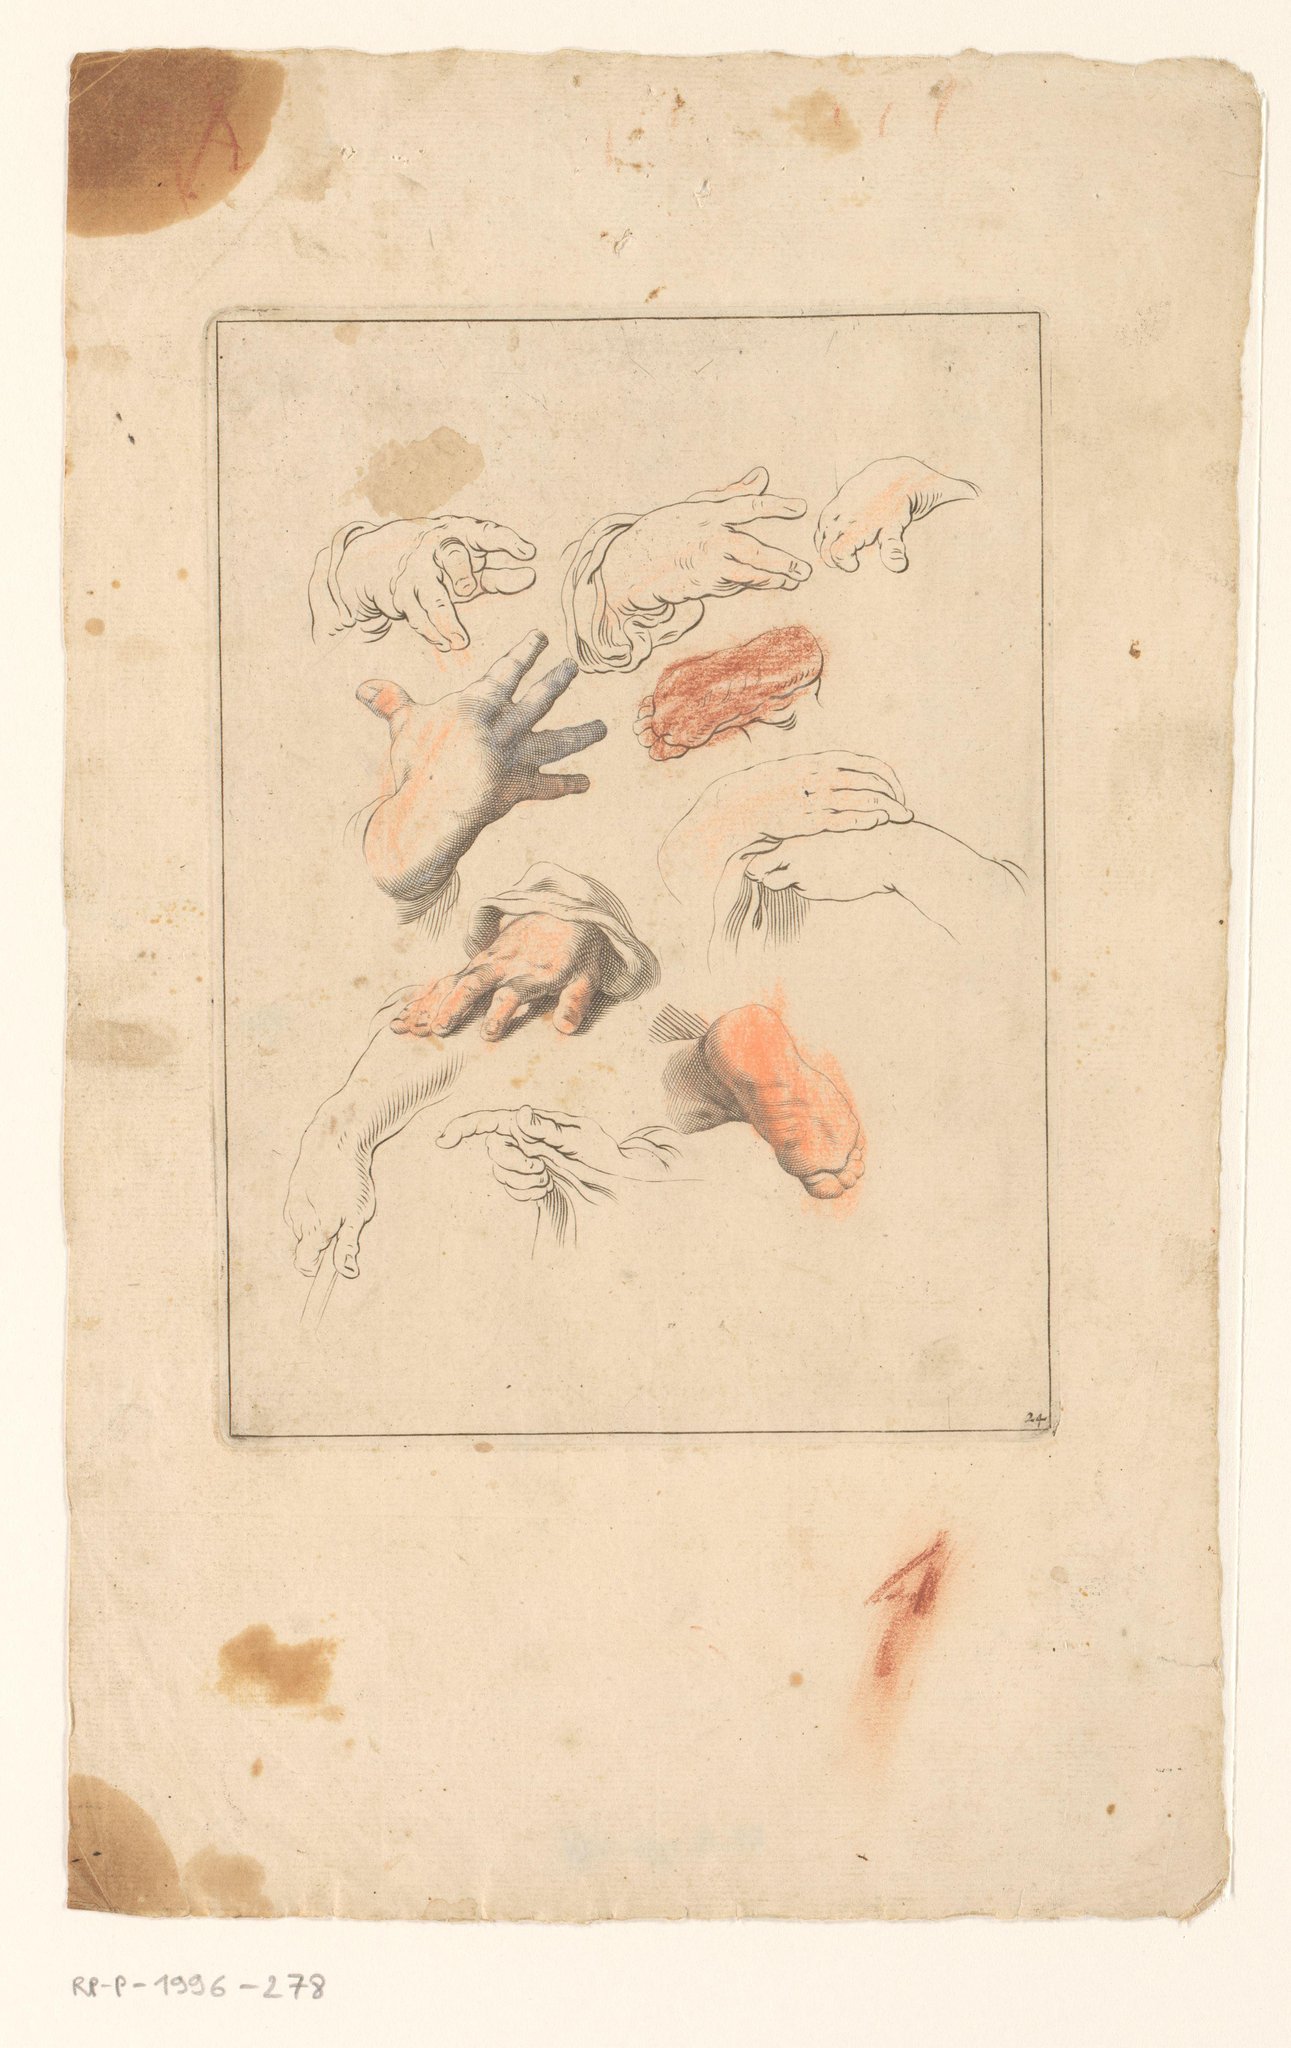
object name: print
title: Handen en twee voetzolen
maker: Anonymous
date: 1650-1750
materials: paper, pencil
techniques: engraving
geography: netherlands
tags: hand, foot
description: Studieblad met handen en voeten uit 'Oorspronkelyk en vermaard Konstryk Tekenboek.' van Abraham Bloemaert. genummerd 24 (de voetzolen zijn met kleurpotlood bruin en oranje ingekleurd (door een kind))